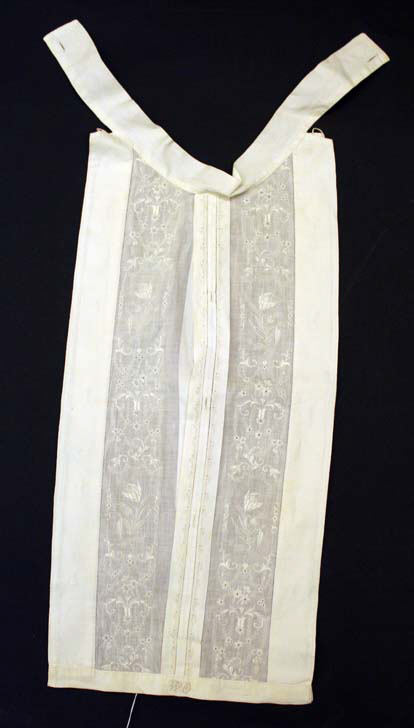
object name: dickey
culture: american or european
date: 1860-1869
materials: linen